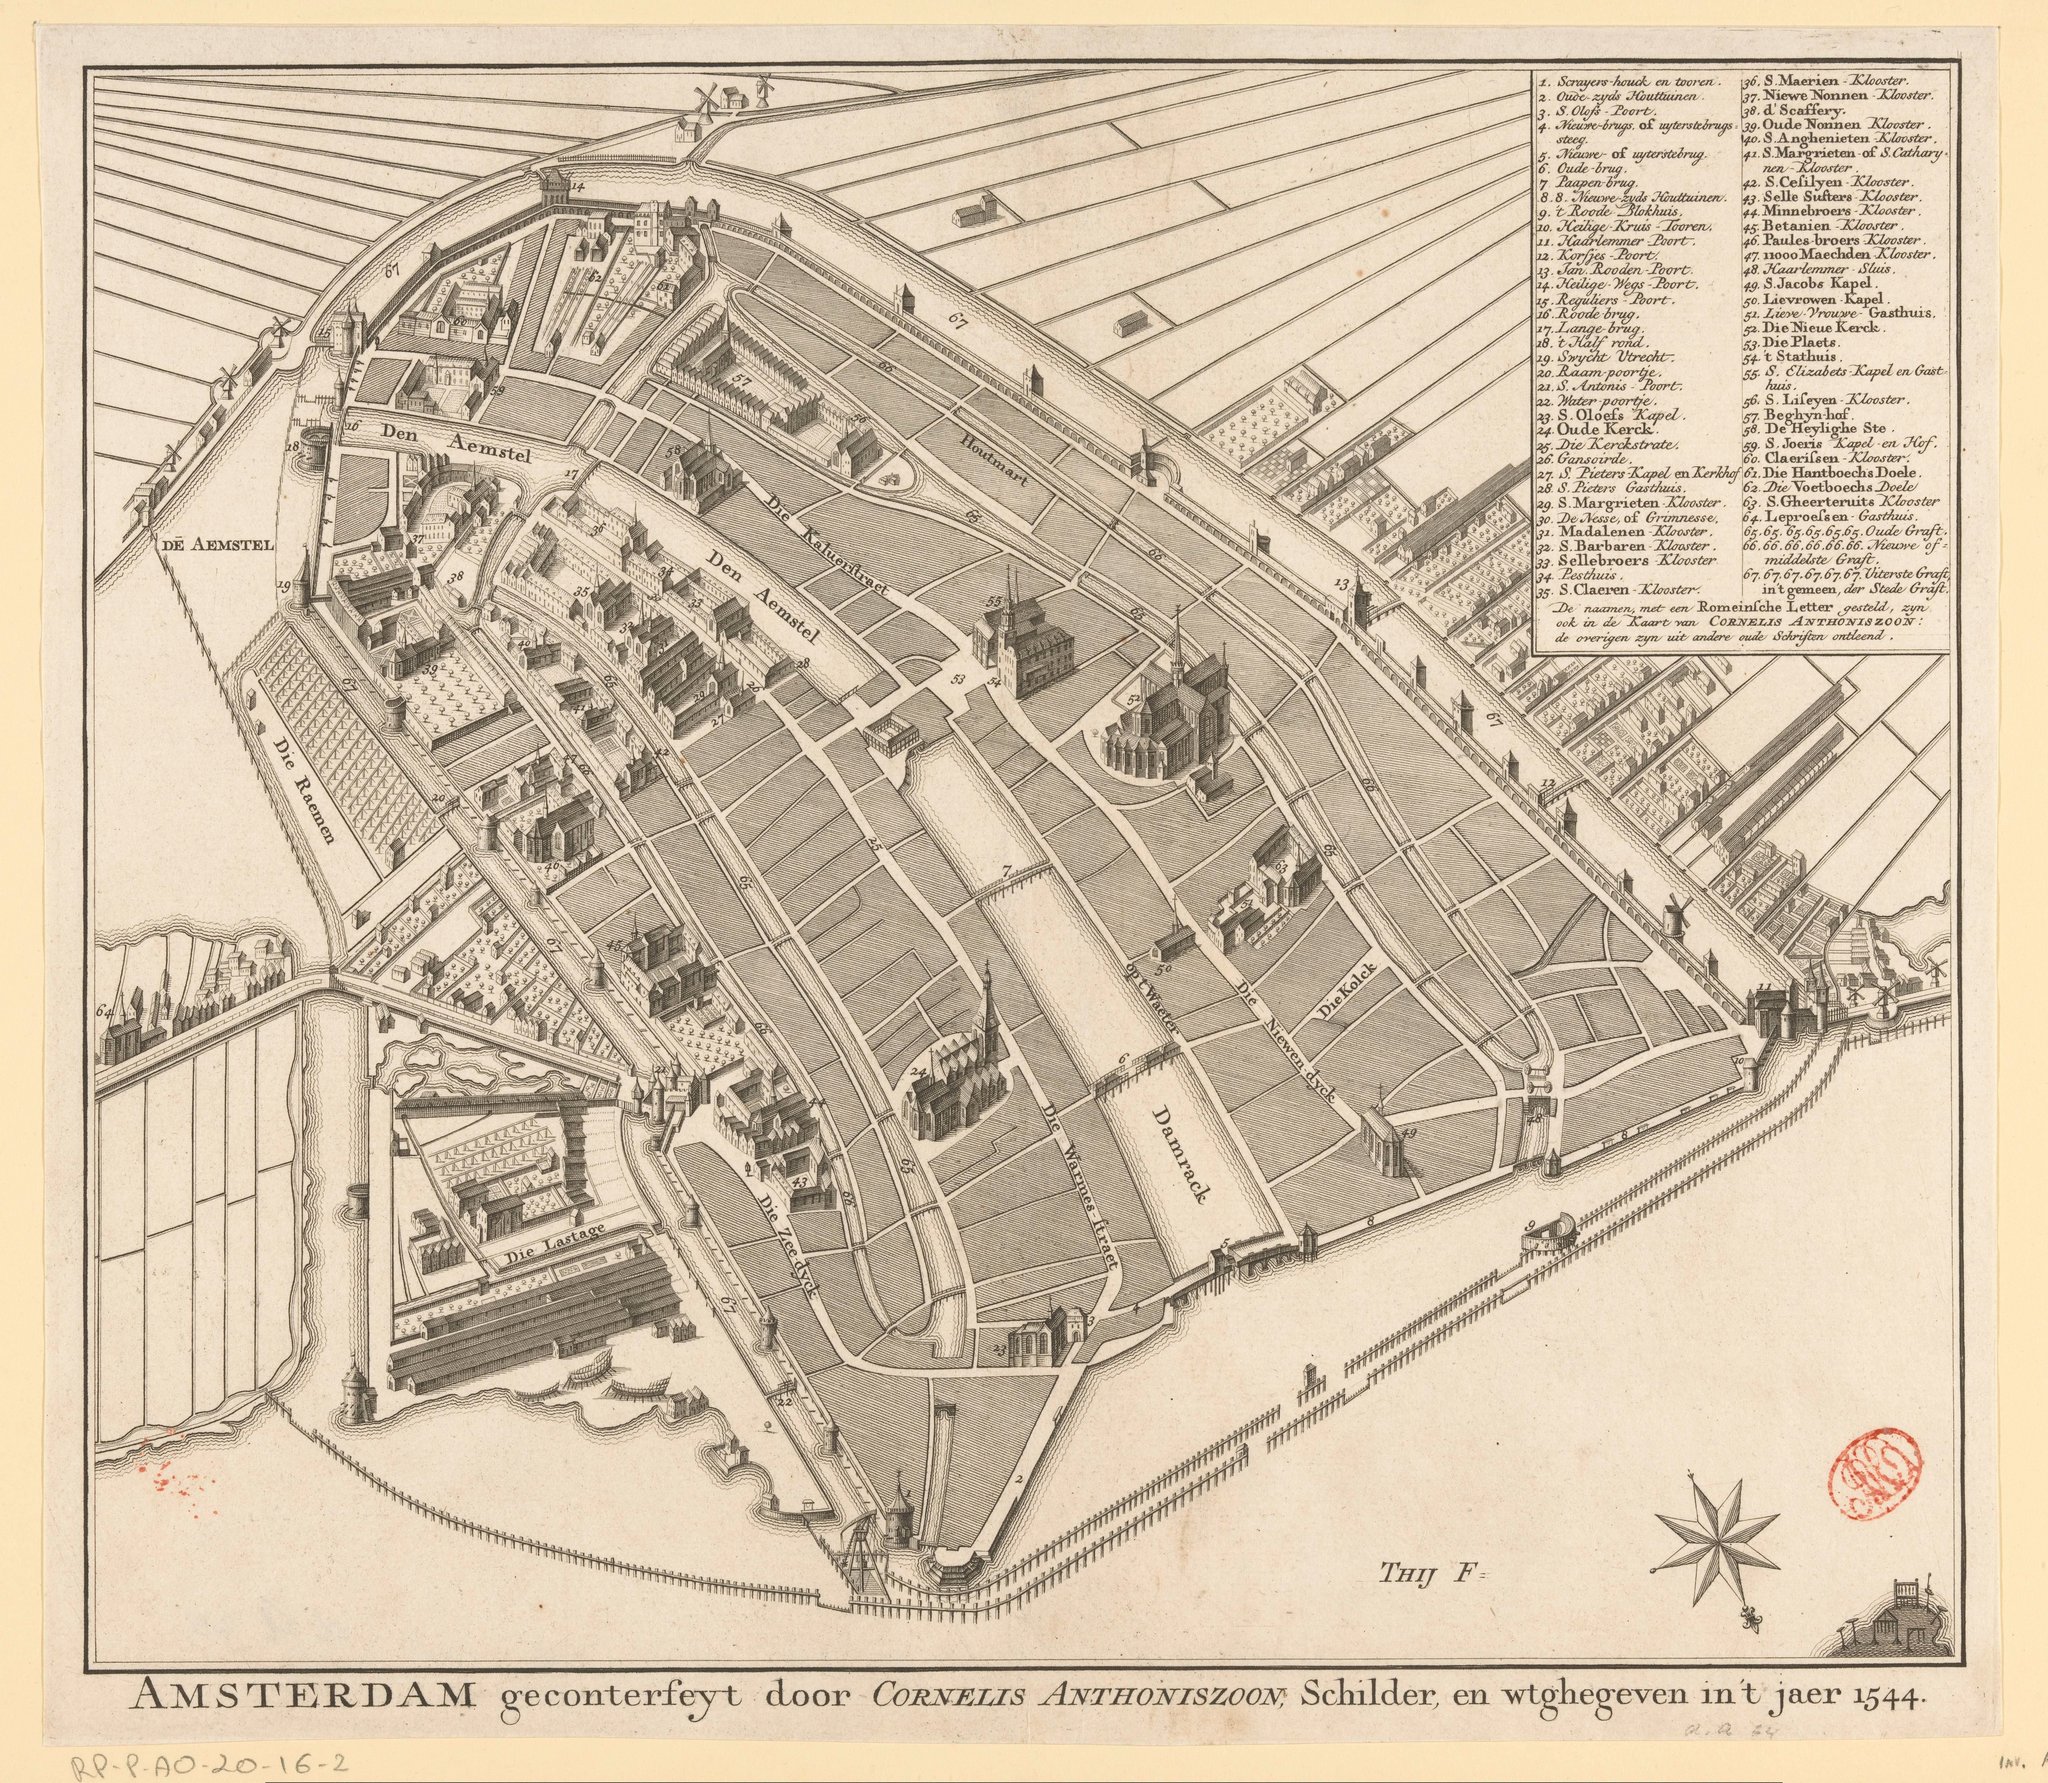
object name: print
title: Plattegrond van Amsterdam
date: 1760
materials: paper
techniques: engraving, etching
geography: amsterdam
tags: maps of cities, amsterdam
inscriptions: collector's mark: Lugt 195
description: Prent ook gebruikt in: Wagenaar, Jan. Amsterdam, in zyne opkomst, aanwas, geschiedenissen (…). 3 delen [folio-uitgave]. Amsterdam: Isaak Tirion en Yntema & Tieboel, 1760-1767, dl. 1 (Isaac Tirion, 1760). En in: Wagenaar, Jan. Amsterdam, in zyne opkomst, aanwas, geschiedenissen (…). 13 delen [octavo-uitgave]. Amsterdam: Isaak Tirion en Yntema & Tieboel, 1760-1768, dl. 1 (Isaac Tirion, 1760).